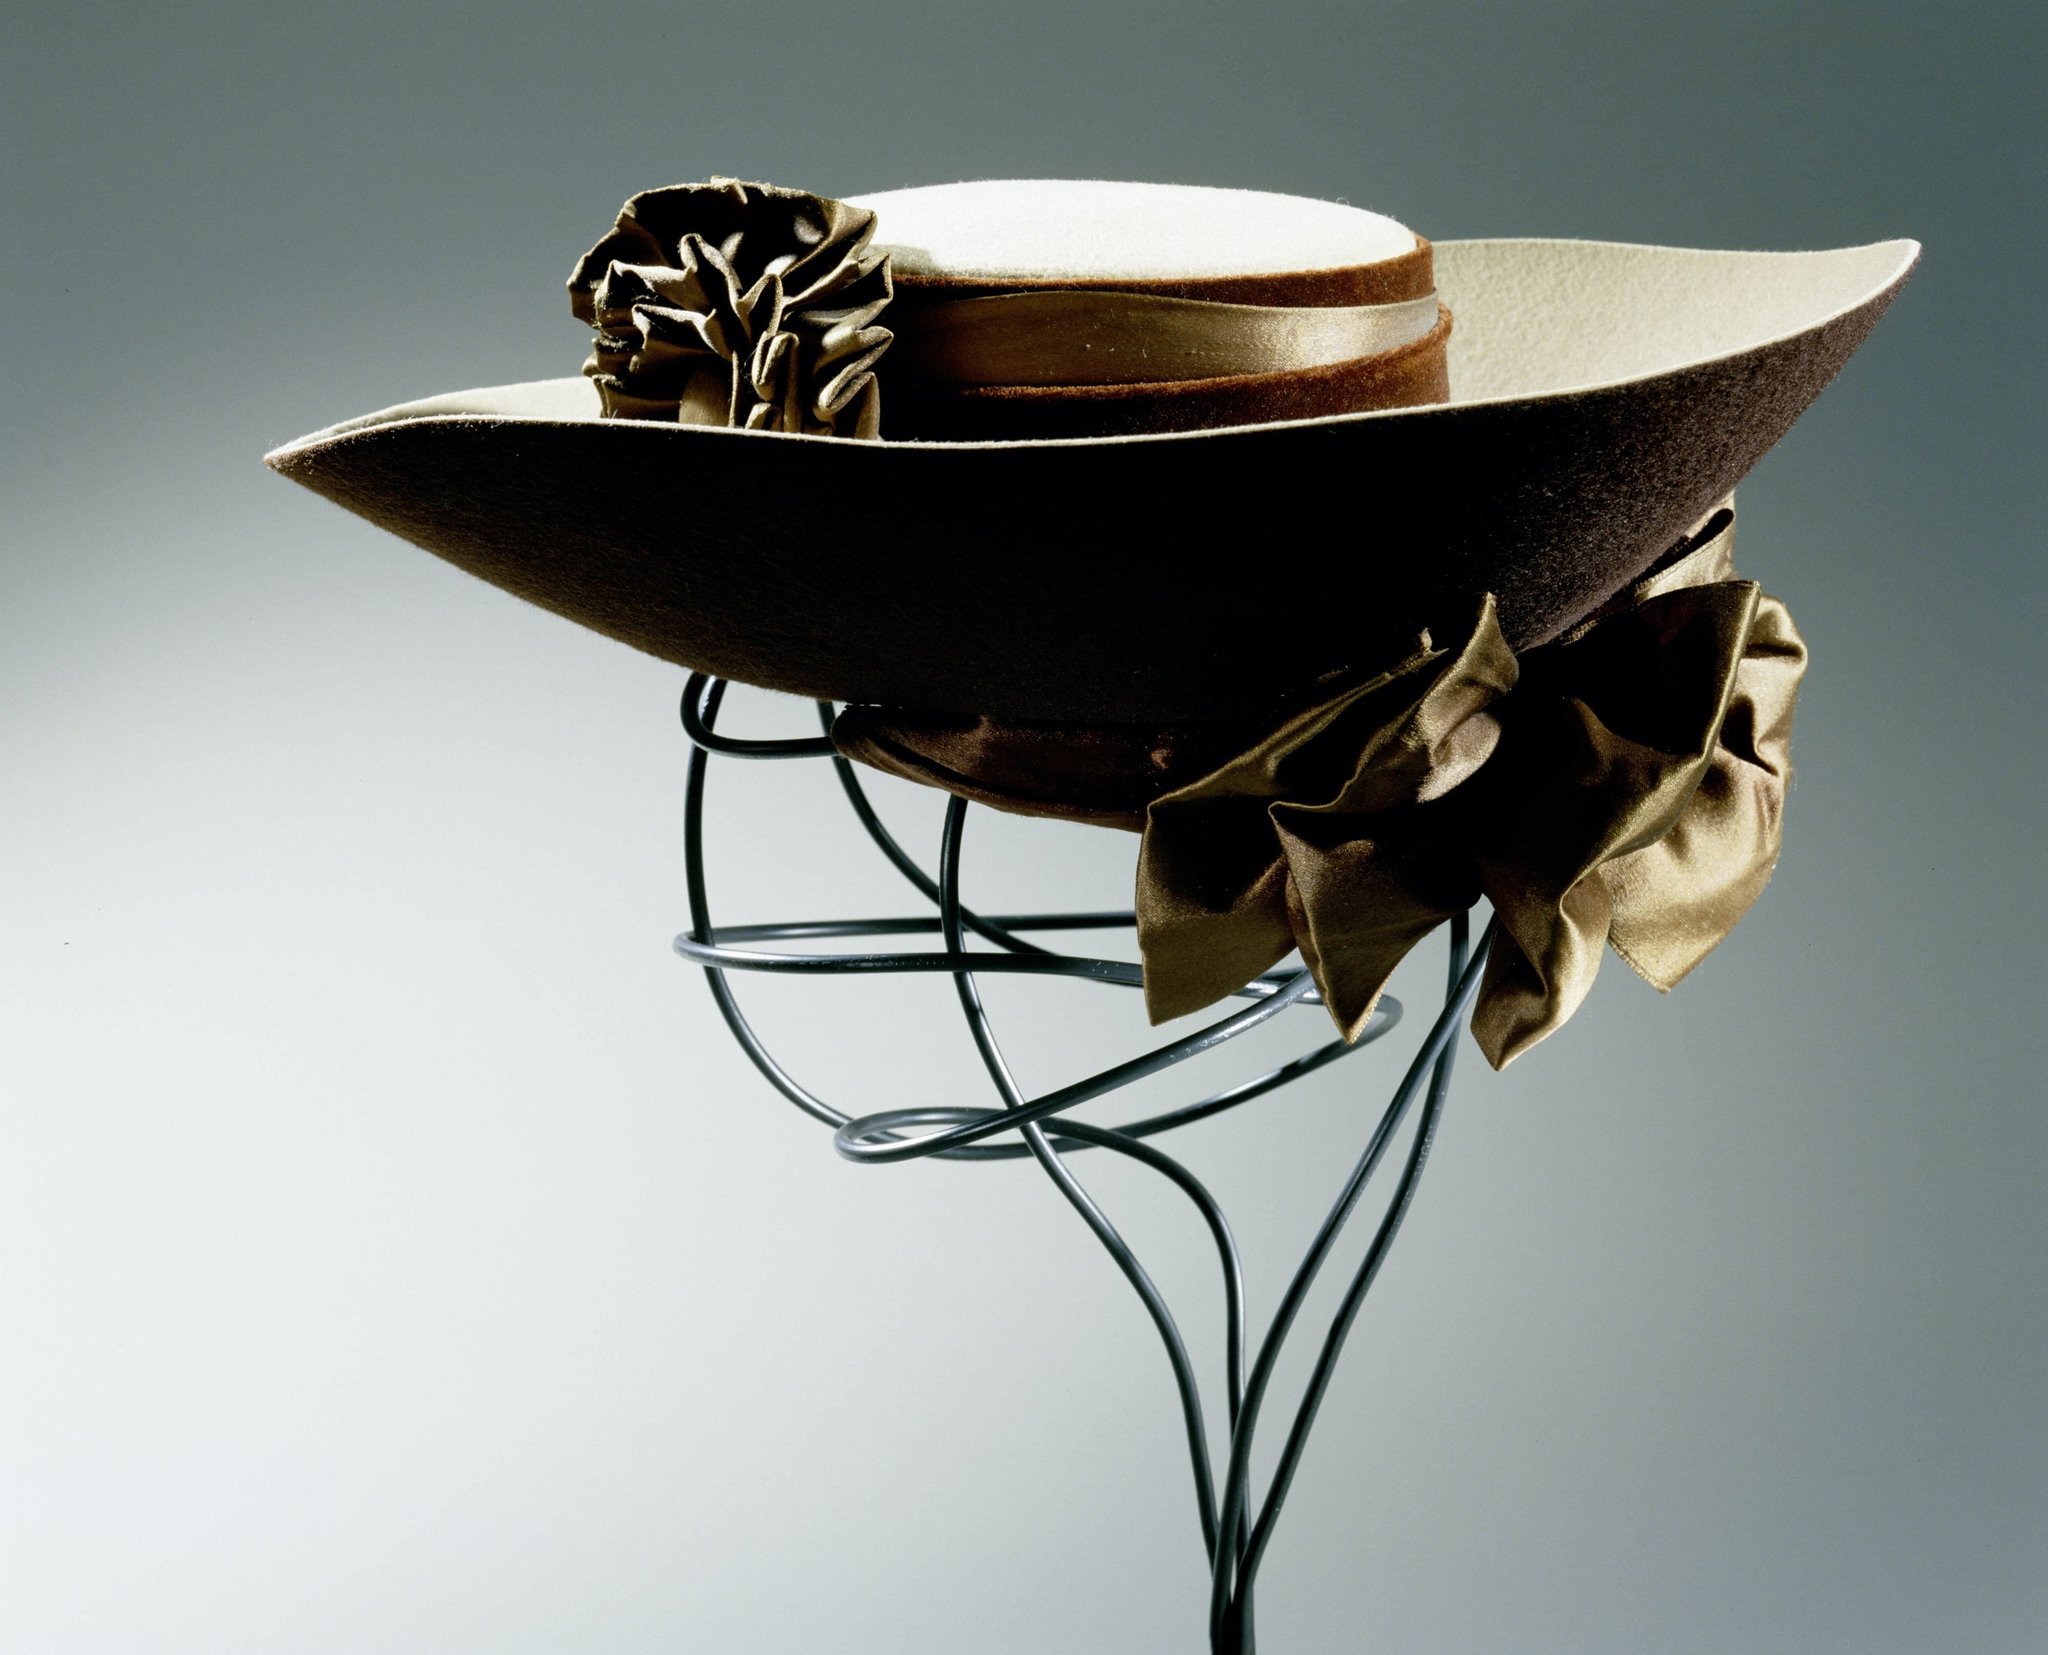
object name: hat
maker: Anonymous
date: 1900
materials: felt, silk, velvet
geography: western europe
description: Hoed van vilt, brede rand. Bovenkant beige, onderkant bruin. Om de bol een bruin fluwelen band met zijden strik. Aan de achterkant een dito strik.